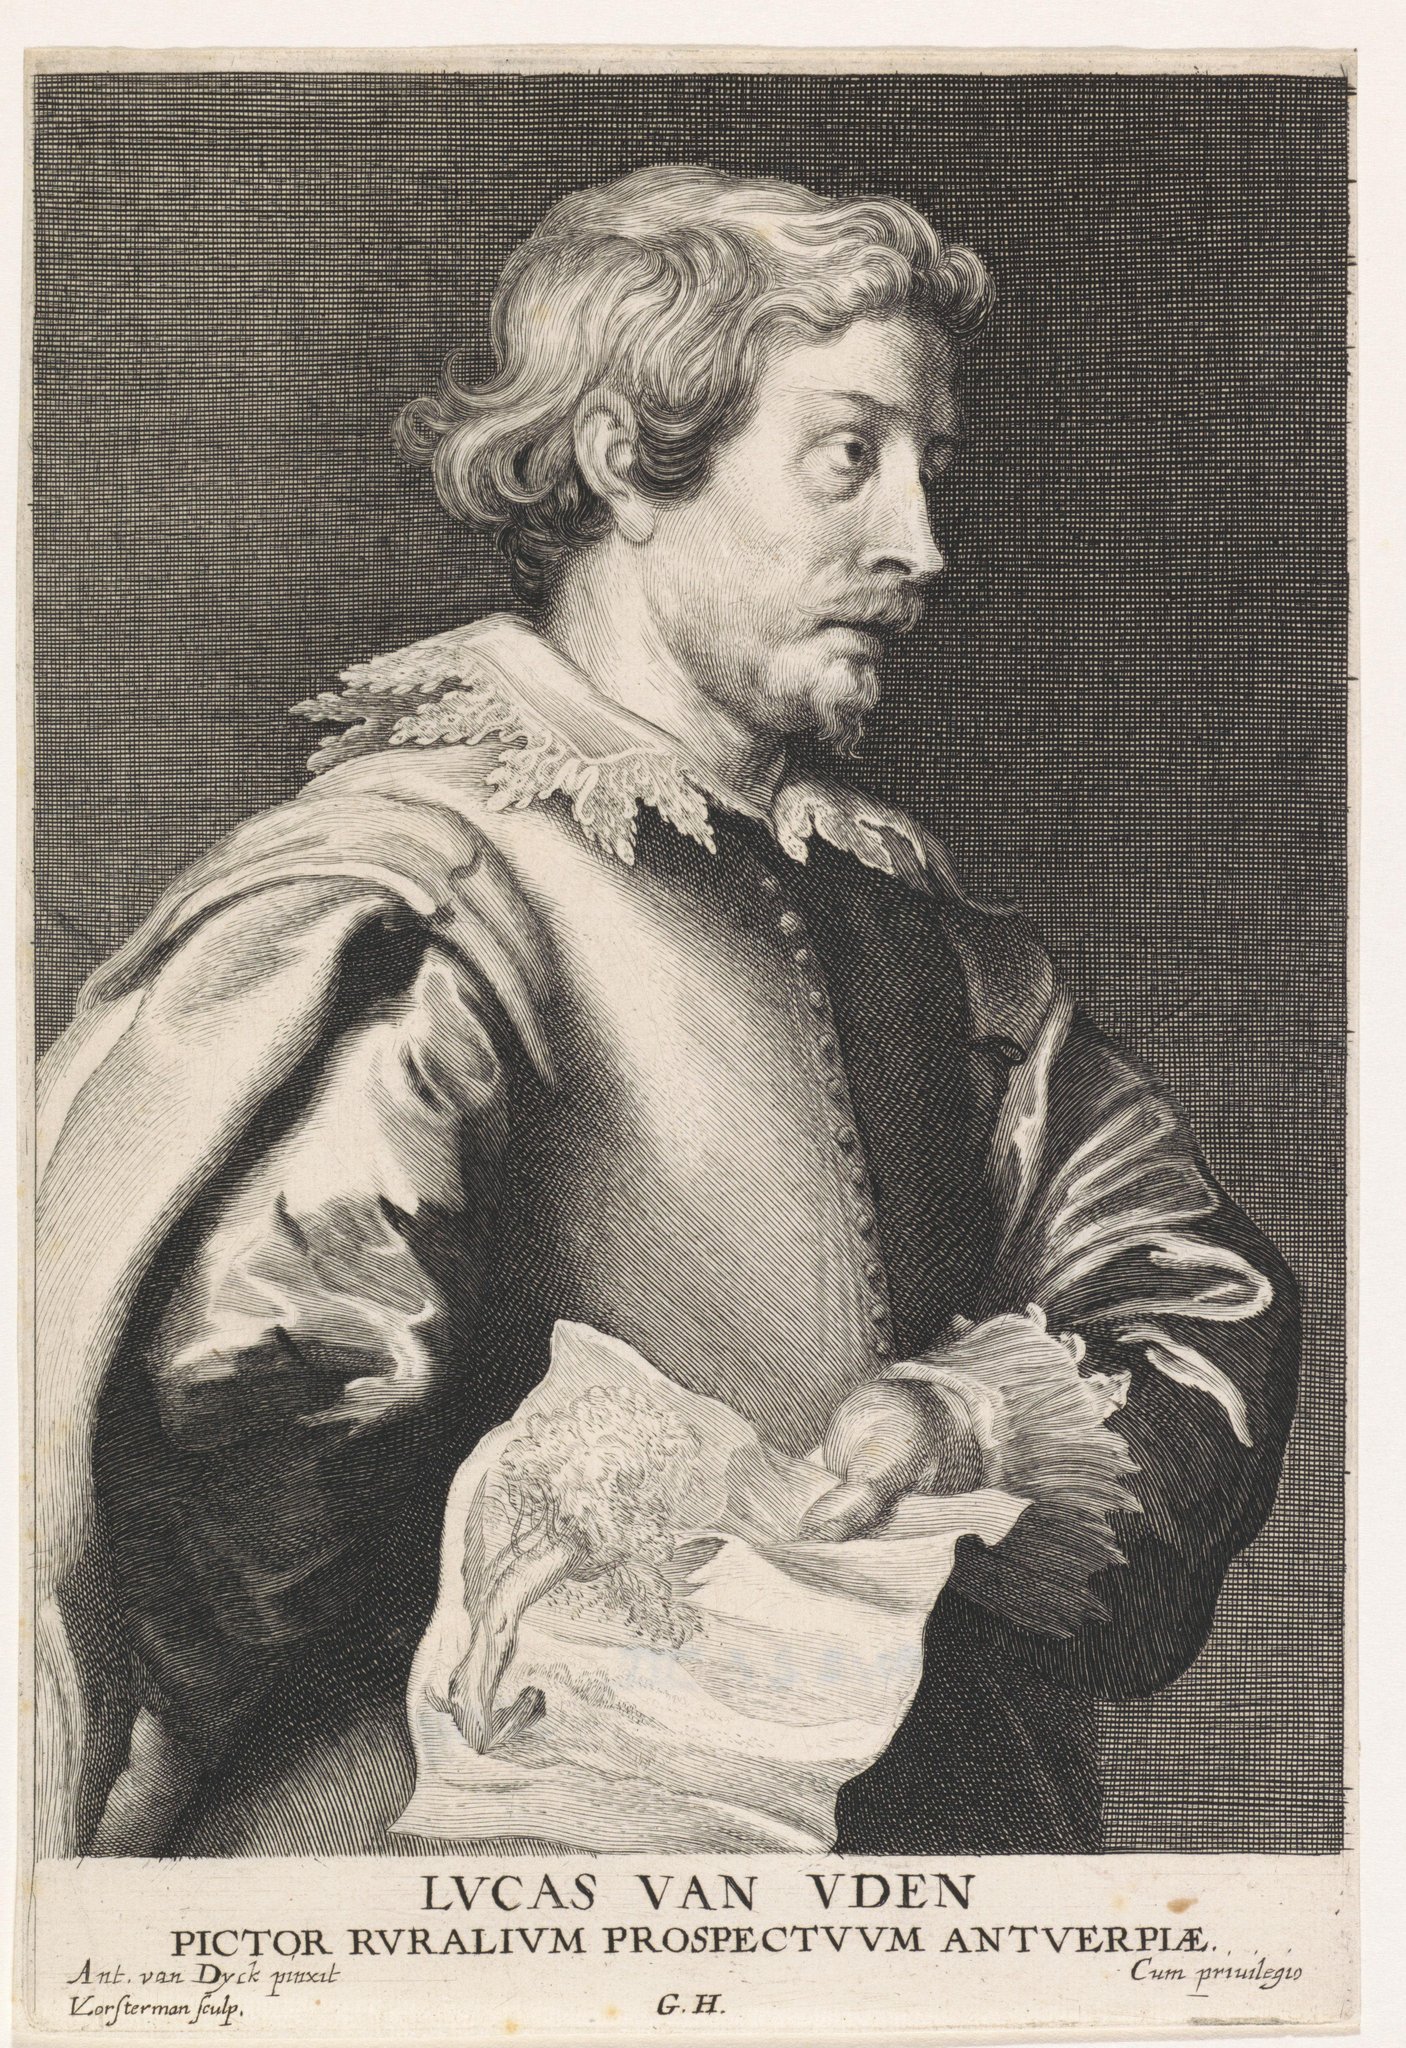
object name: print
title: Iconographie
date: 1645-1646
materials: paper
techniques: engraving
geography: antwerp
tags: antwerp, print maker, draughtsman, lucas van uden, drawing, sketch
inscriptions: collector's mark: Lugt 240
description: Prent gebruikt voor: Icones principum, virorum doctorum, pictorum, chalcographorum, statuariorum nec non amatorum pictoriae artis numero centum ab Ant. van Dyck ad vivum expressae ejusque sumptibus aeri incisae. Antwerpen: Gillis Hendricx, [1645-1646].